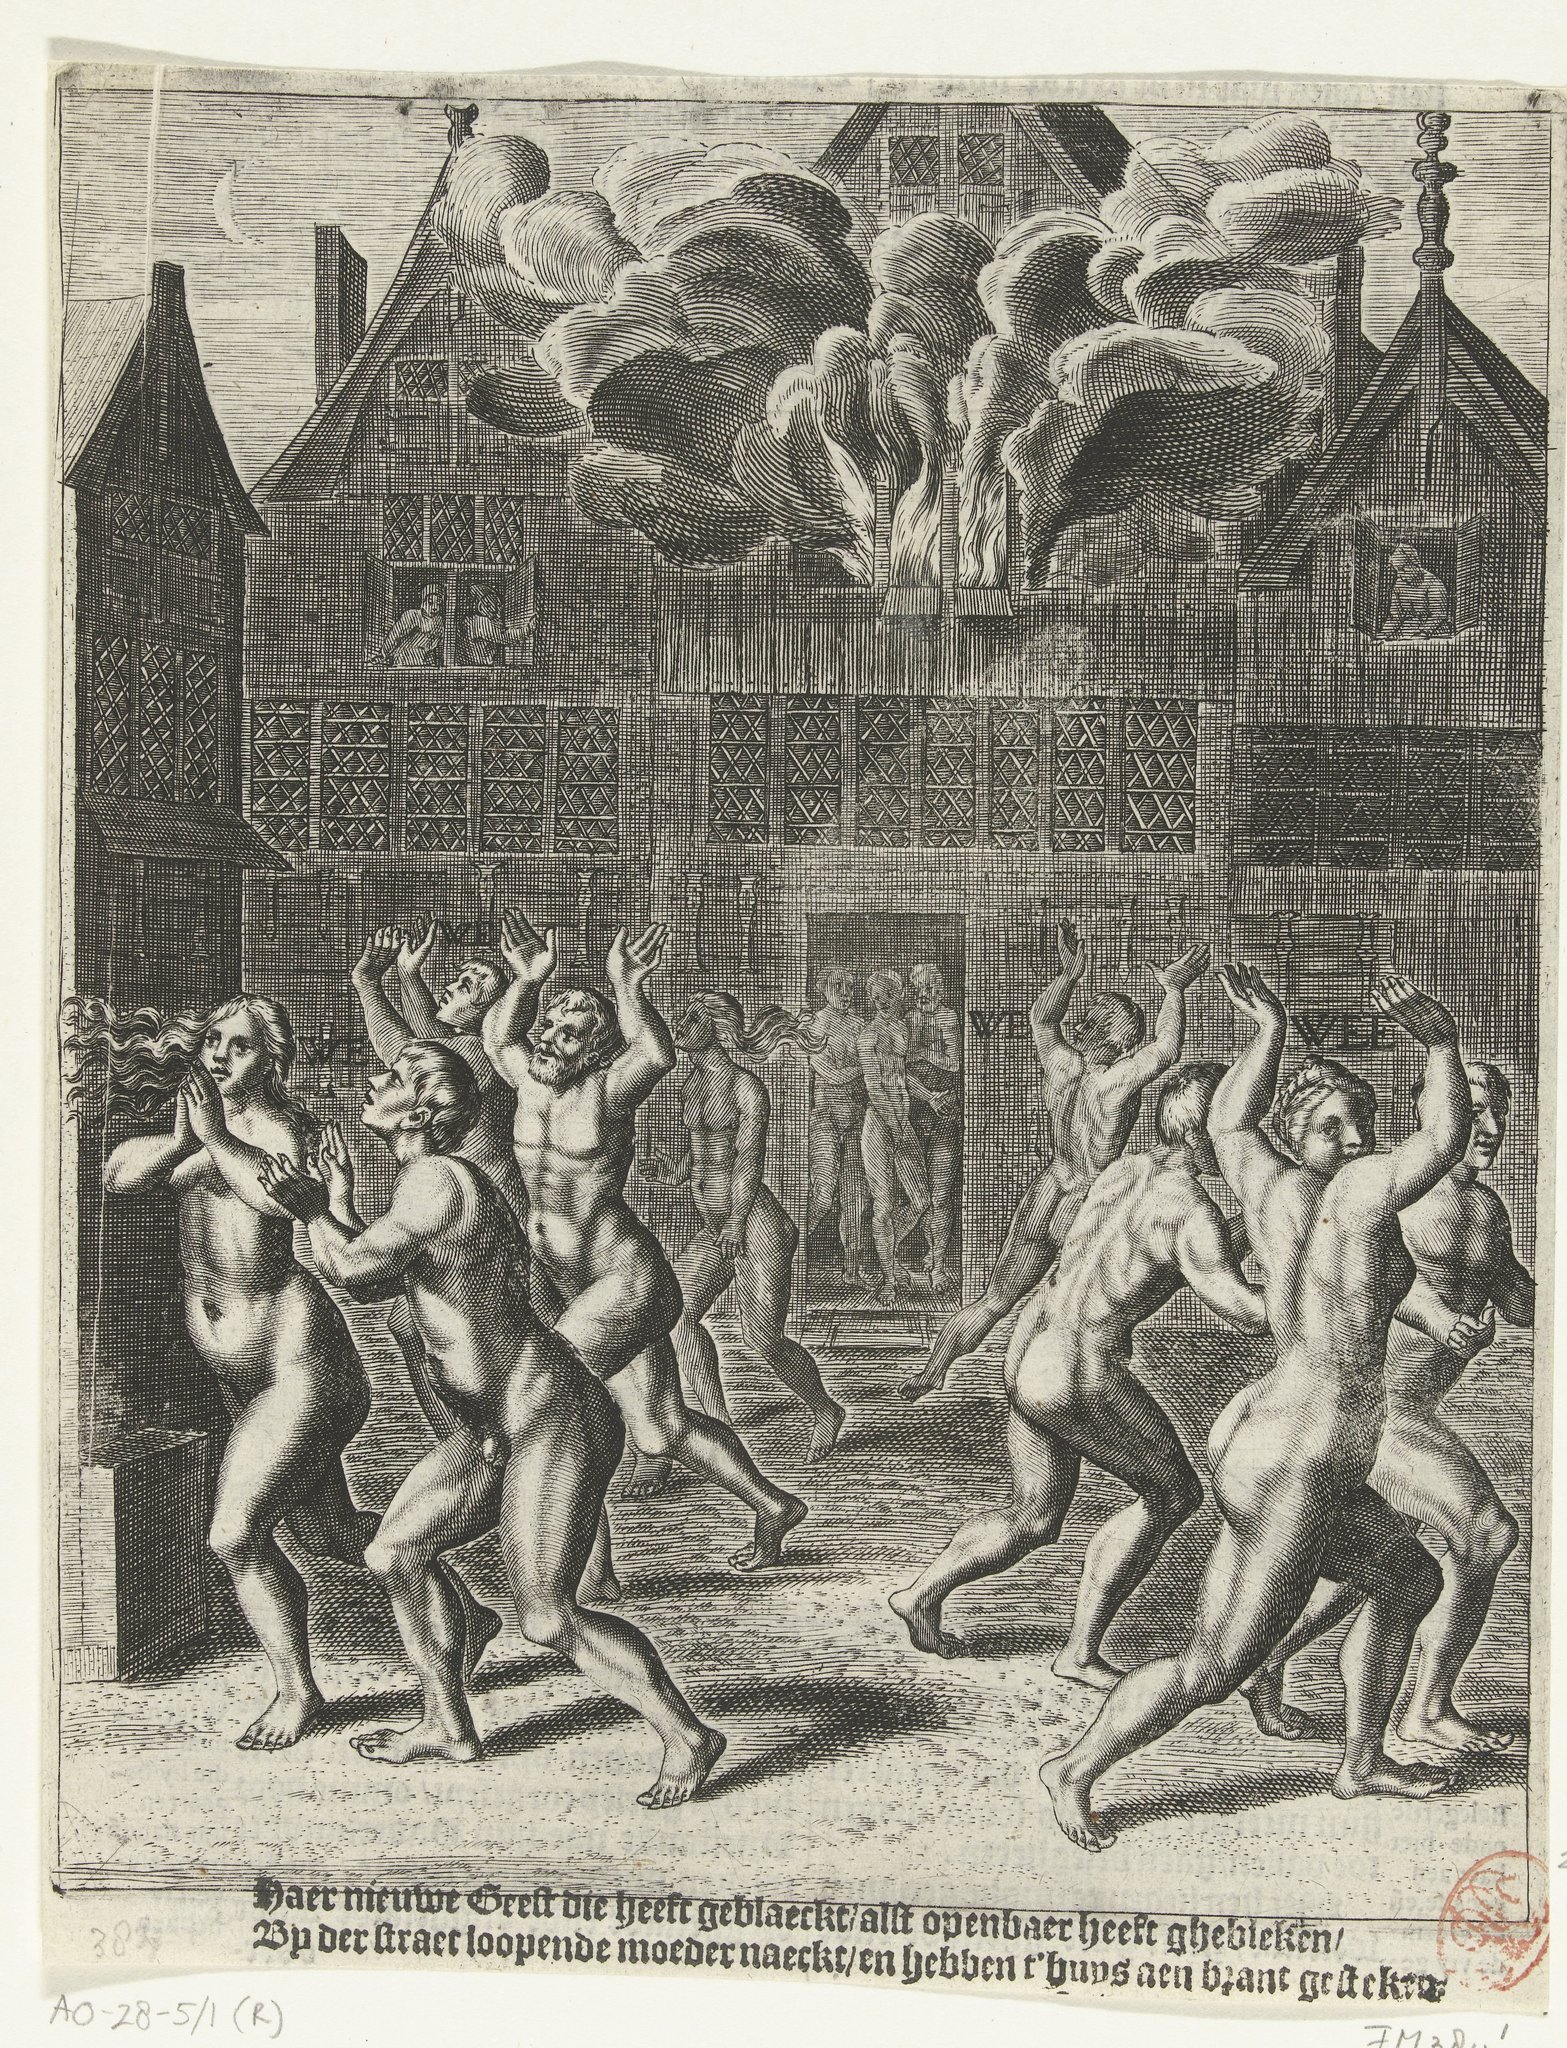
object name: history print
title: Naaktlopers te Amsterdam, 1535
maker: Anonymous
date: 1612-1614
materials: paper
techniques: engraving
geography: northern netherlands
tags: amsterdam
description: Illustratie uit: L. Hortensius, Het boeck D. Lamberti Hortensii (...). Van den oproer der weder-dooperen, J. L. Meyn, Enkhuizen 1614, p. 18. Naar het verloren gegane schilderij van Barend Dircksz. in het oude stadhuis te Amsterdam.